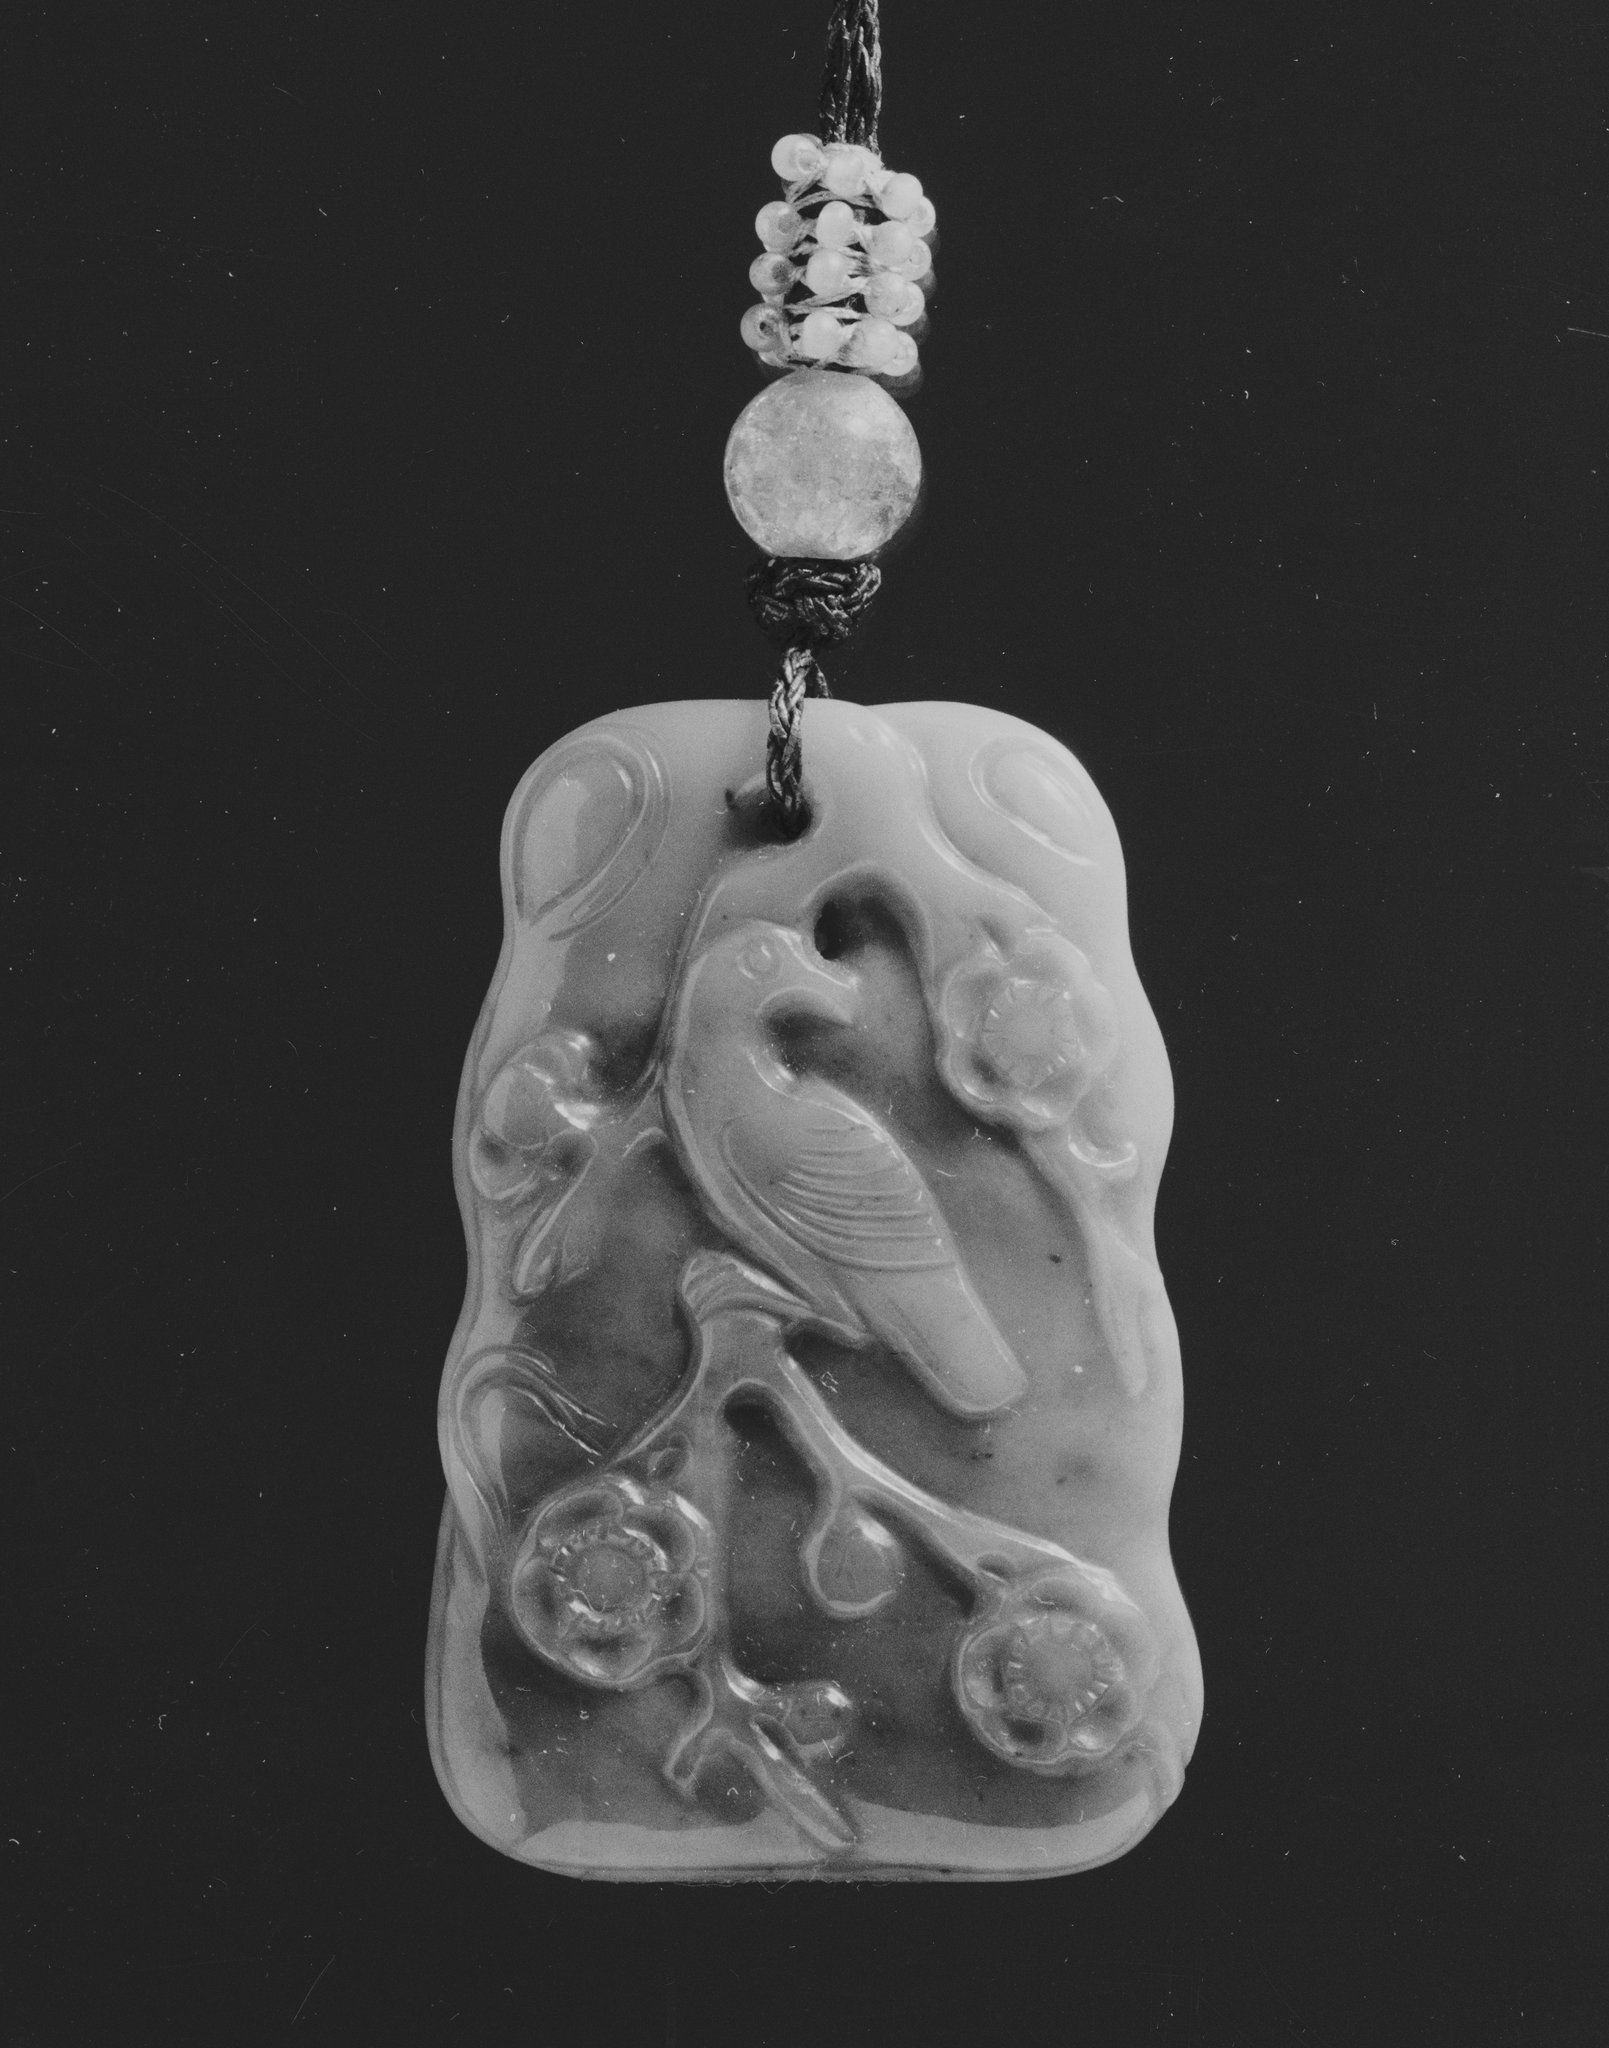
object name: pendant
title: Pendants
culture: chinese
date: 1901-2000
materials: jade, pearl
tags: birds